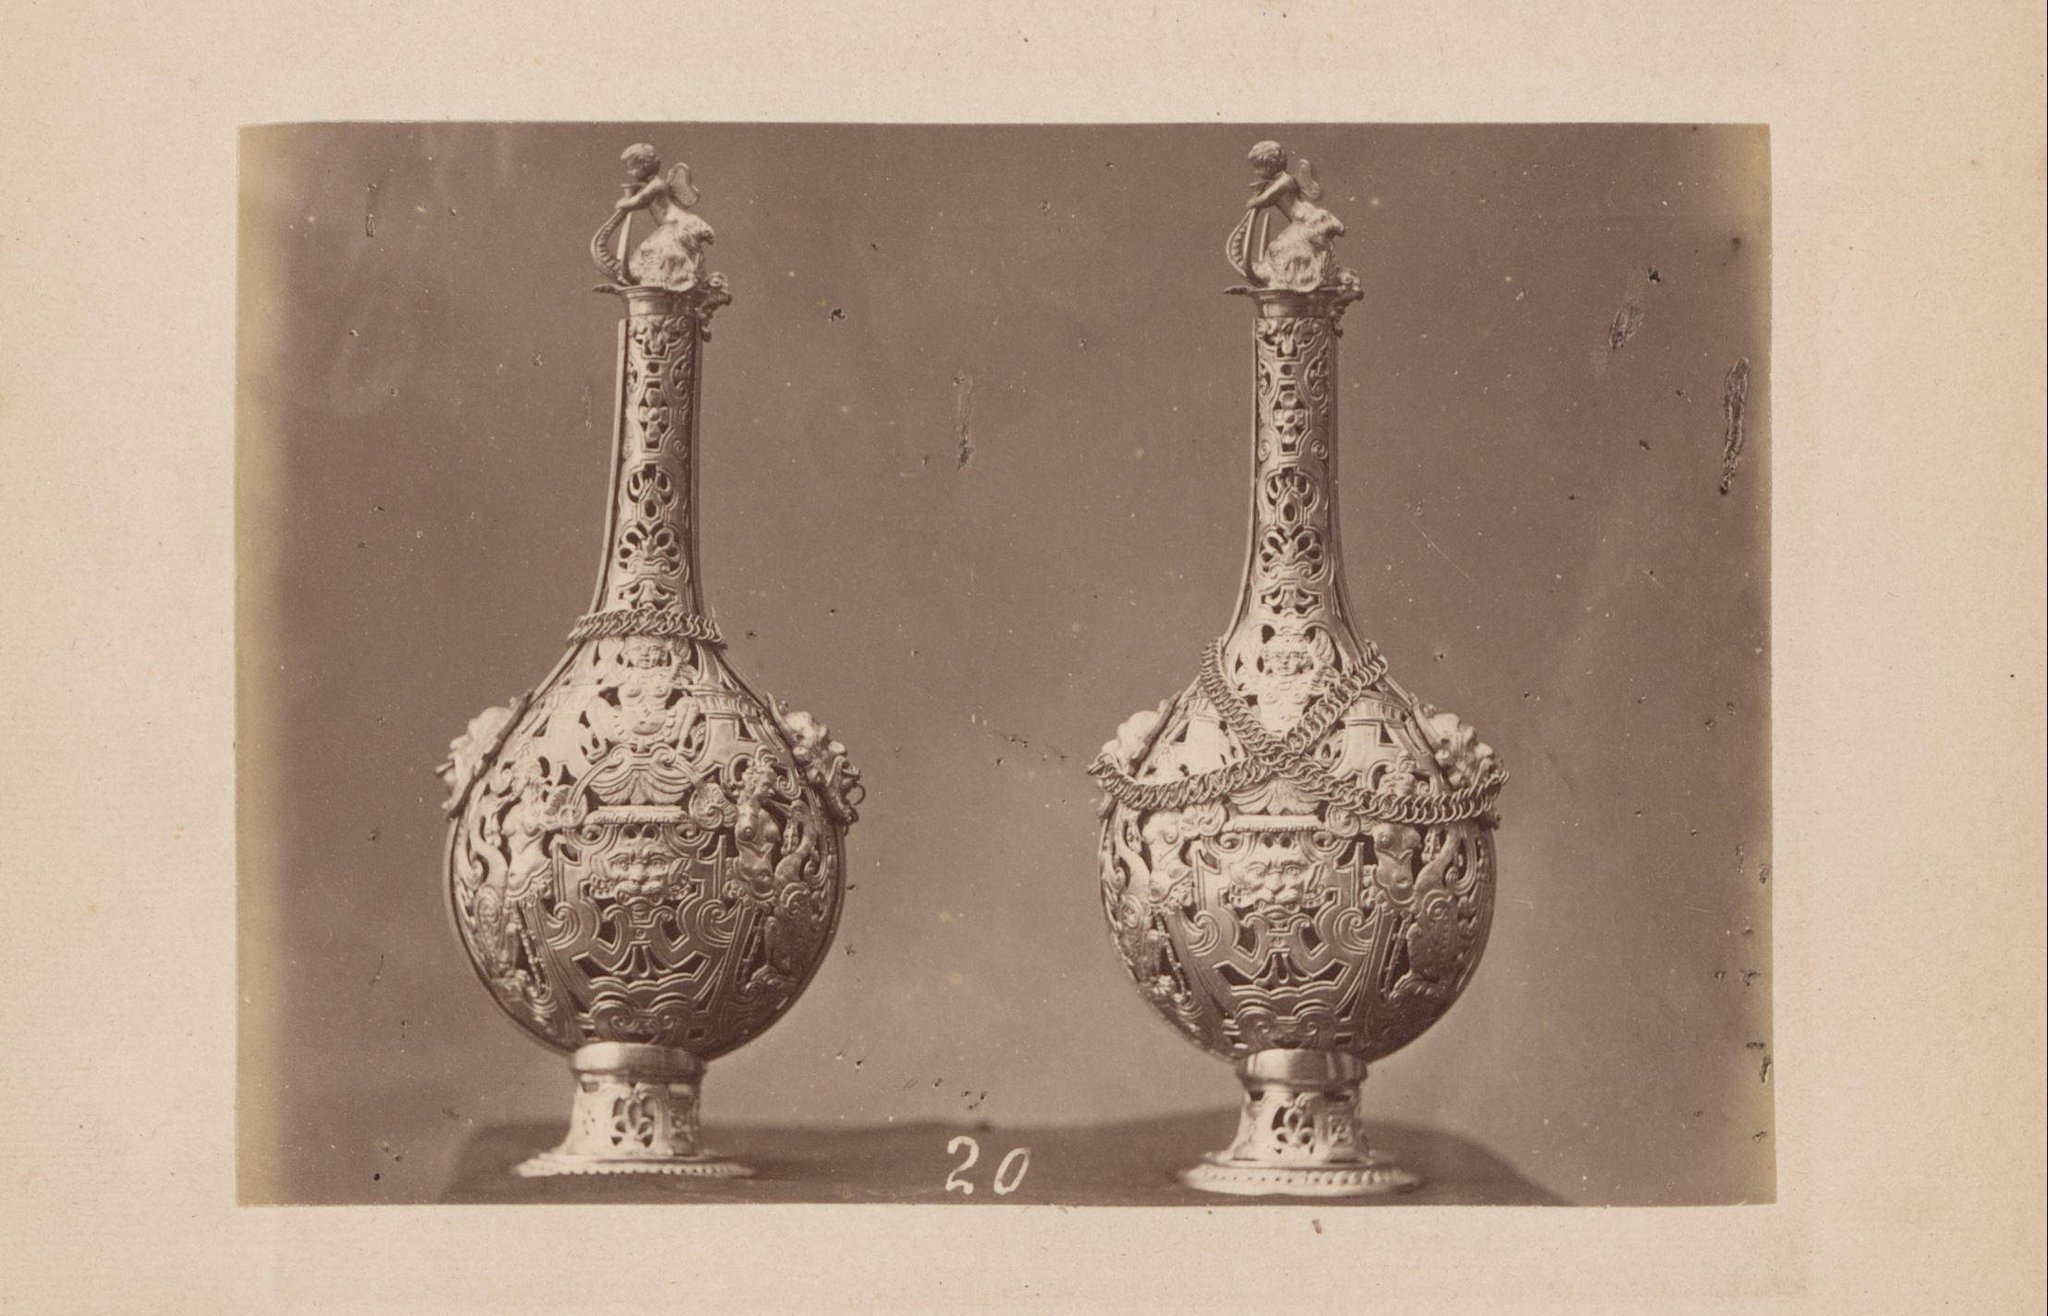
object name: page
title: Twee monturen voor flessen uit de 16de eeuw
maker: Anonymous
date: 1860-1885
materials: photographic support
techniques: albumen print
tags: container of metal: bucket, can, canister, drum, tin